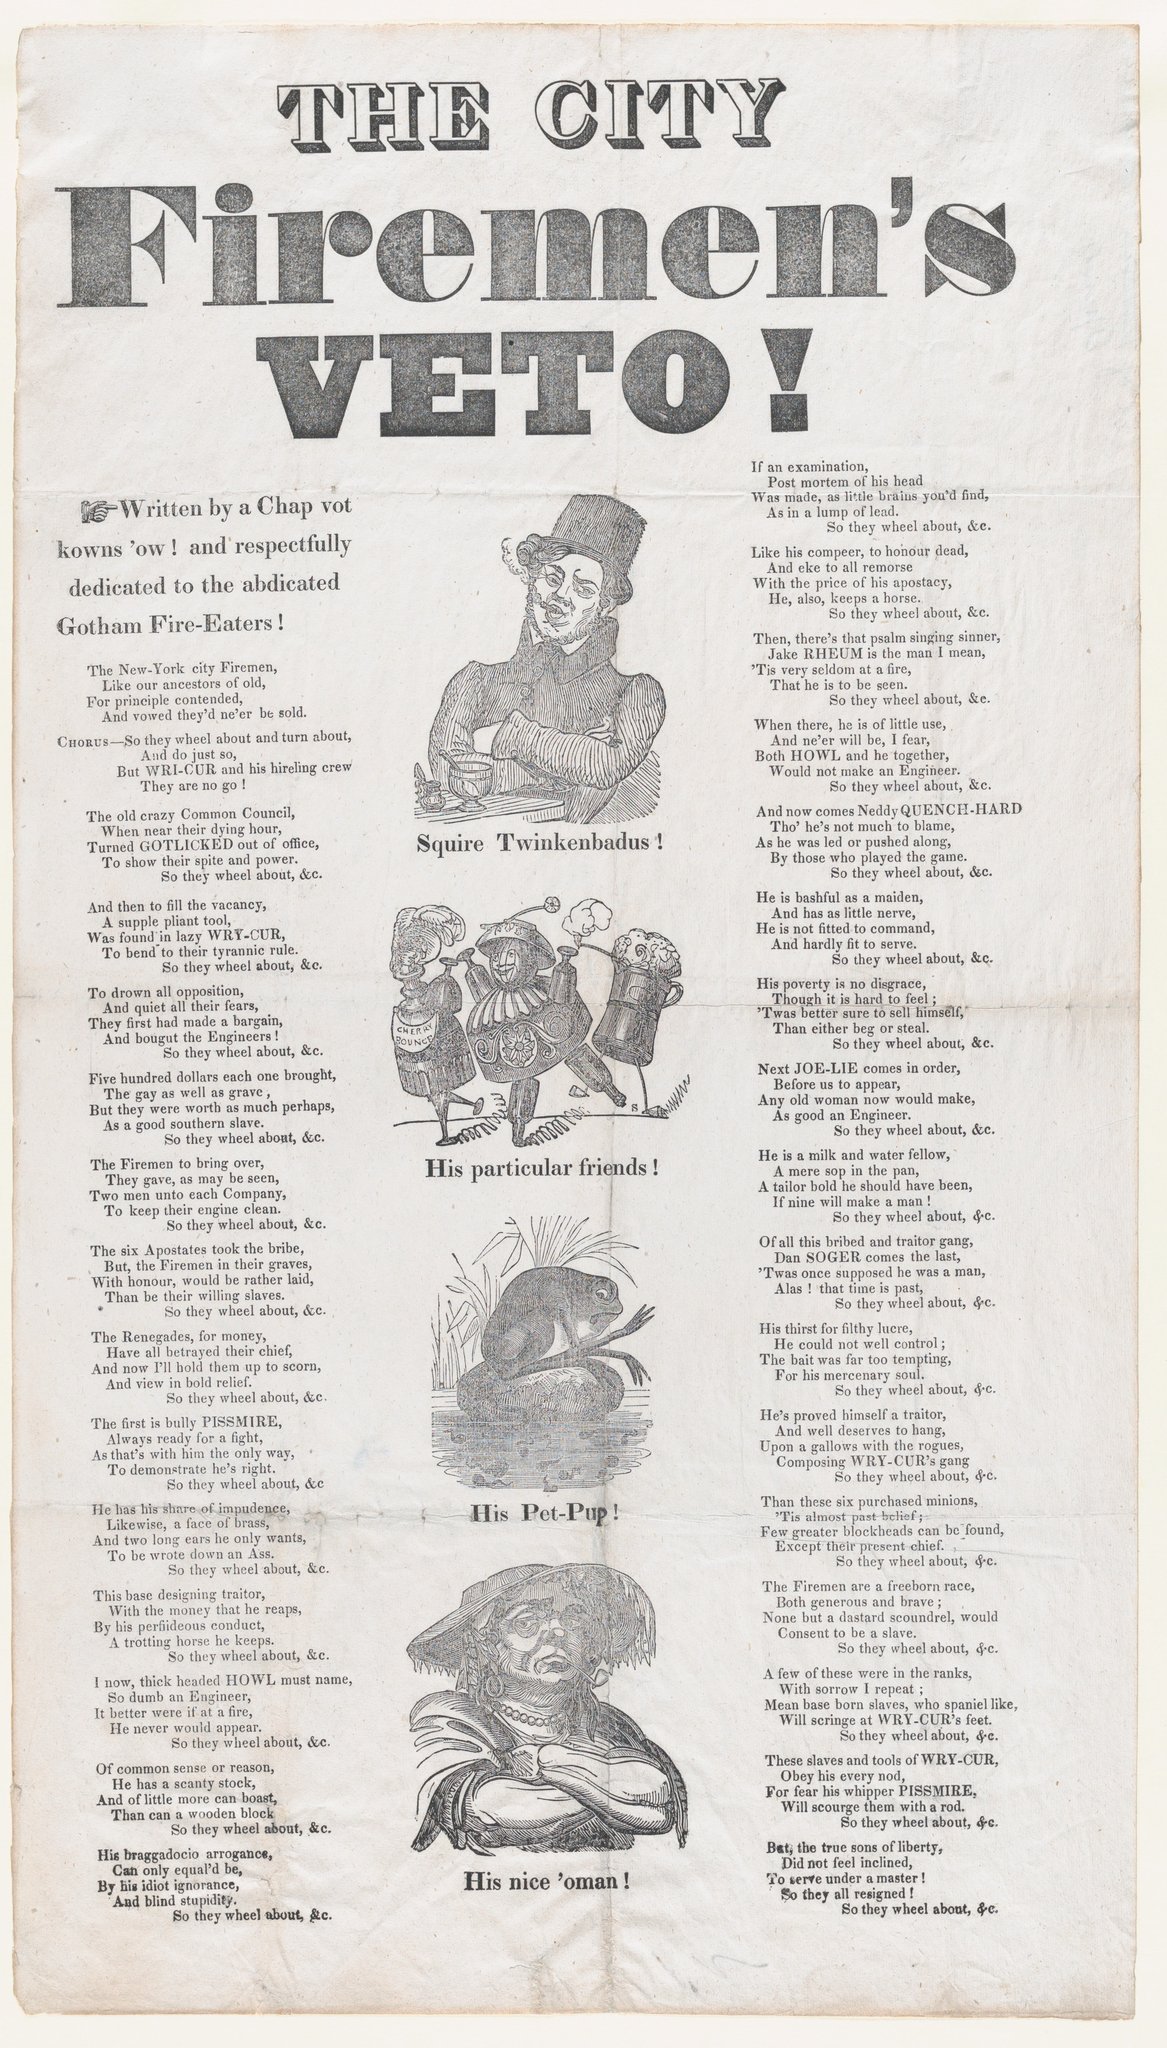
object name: print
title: The City Fireman's Veto! Written by a Chap vot knows 'ow! and respectfully dedicated to the abdicated Gotham Fire-Eaters!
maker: anonymous, american, 19th century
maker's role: artist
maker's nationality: american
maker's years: 1800-1900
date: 1836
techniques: woodcut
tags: men,frogs,caricature